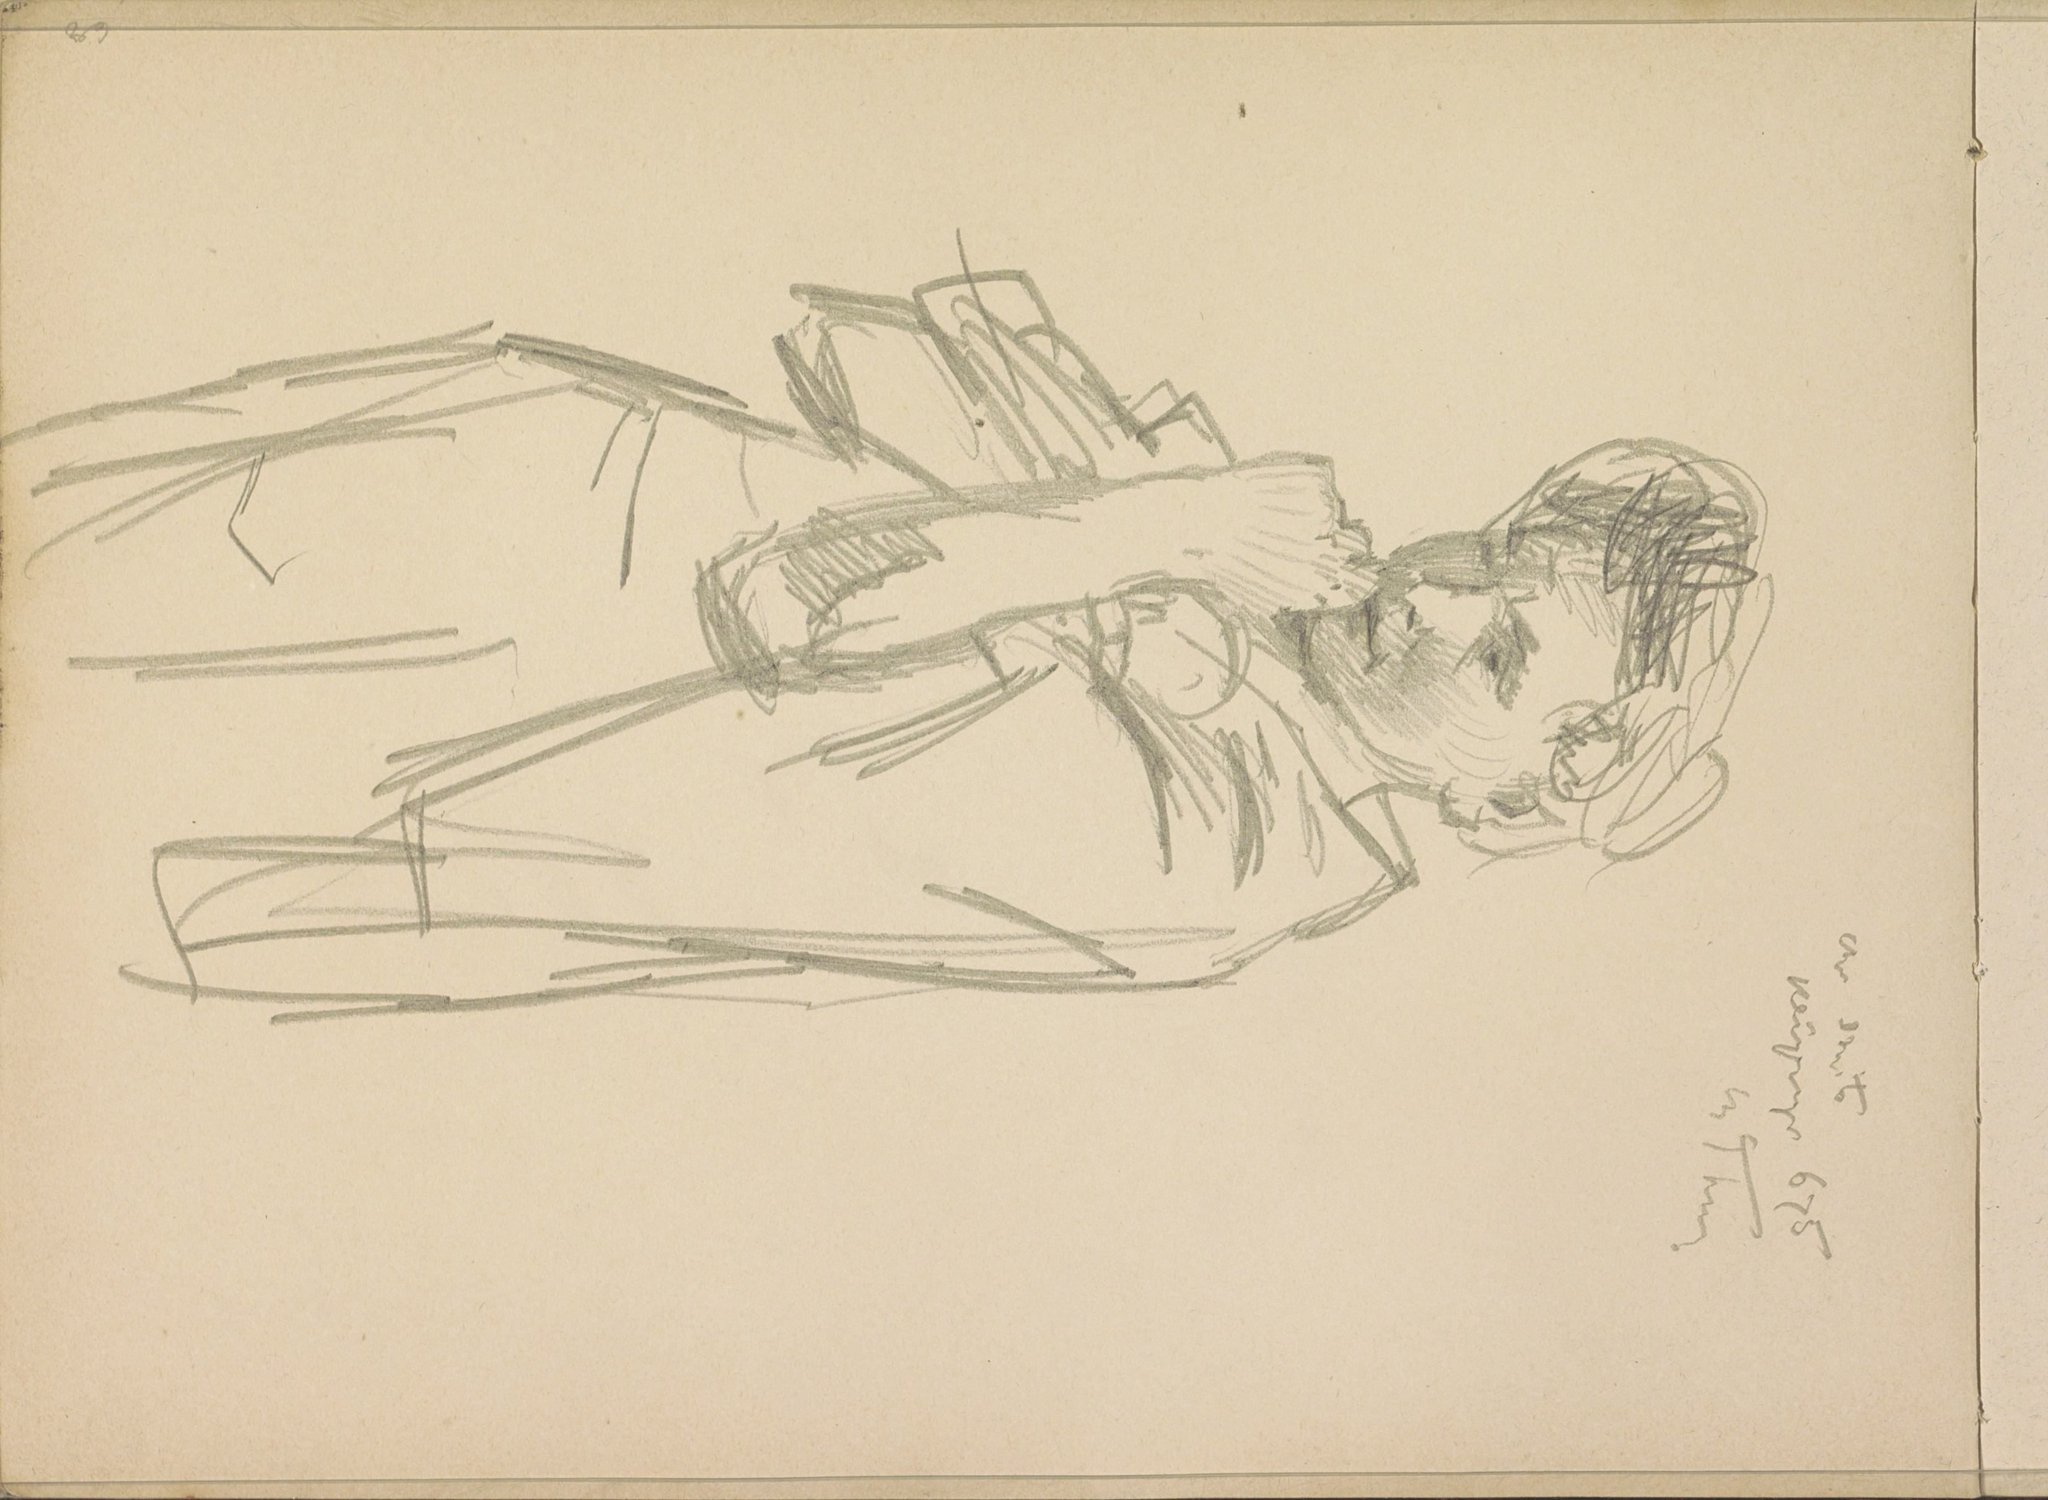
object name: sketchbook leaf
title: Staande vrouw met omslagdoek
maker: isaac israels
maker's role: draughtsman, painter, print maker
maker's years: 1865-1934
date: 1890-1920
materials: paper, pencil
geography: the hague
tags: adult woman (+ standing)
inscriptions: annotation: ‘dhr Smits / Kiezersgr 675 / en thuis[?]’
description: Blad 19 verso uit schetsboek X met 43 bladen.